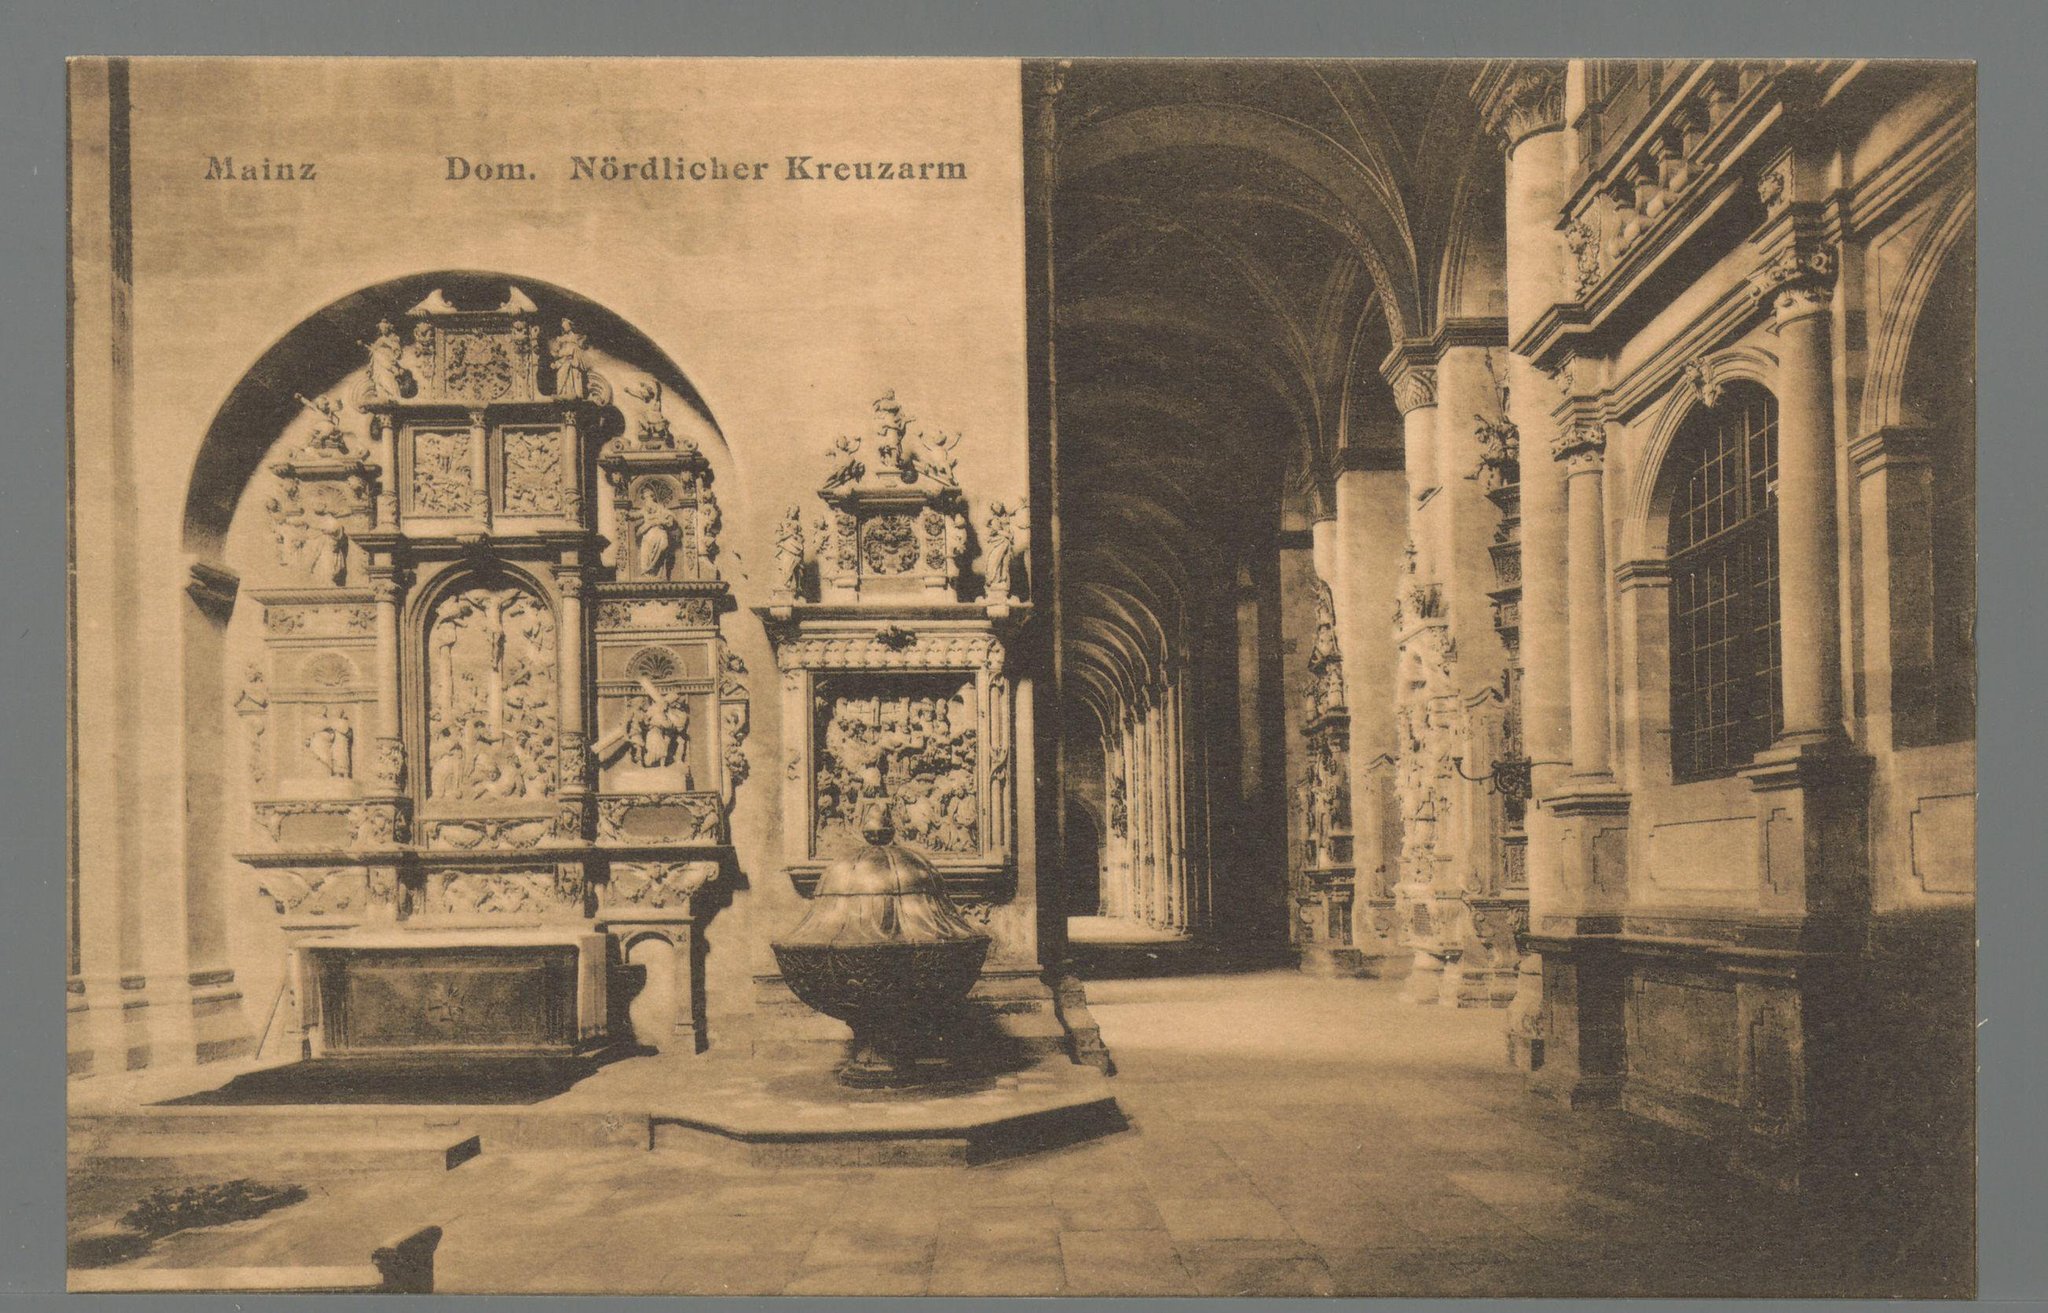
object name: photomechanical print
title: Mainz. Dom. Nördlicher Kreuzarm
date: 1906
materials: cardboard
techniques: photograph, writing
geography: magdeburg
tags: interior of church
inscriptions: date